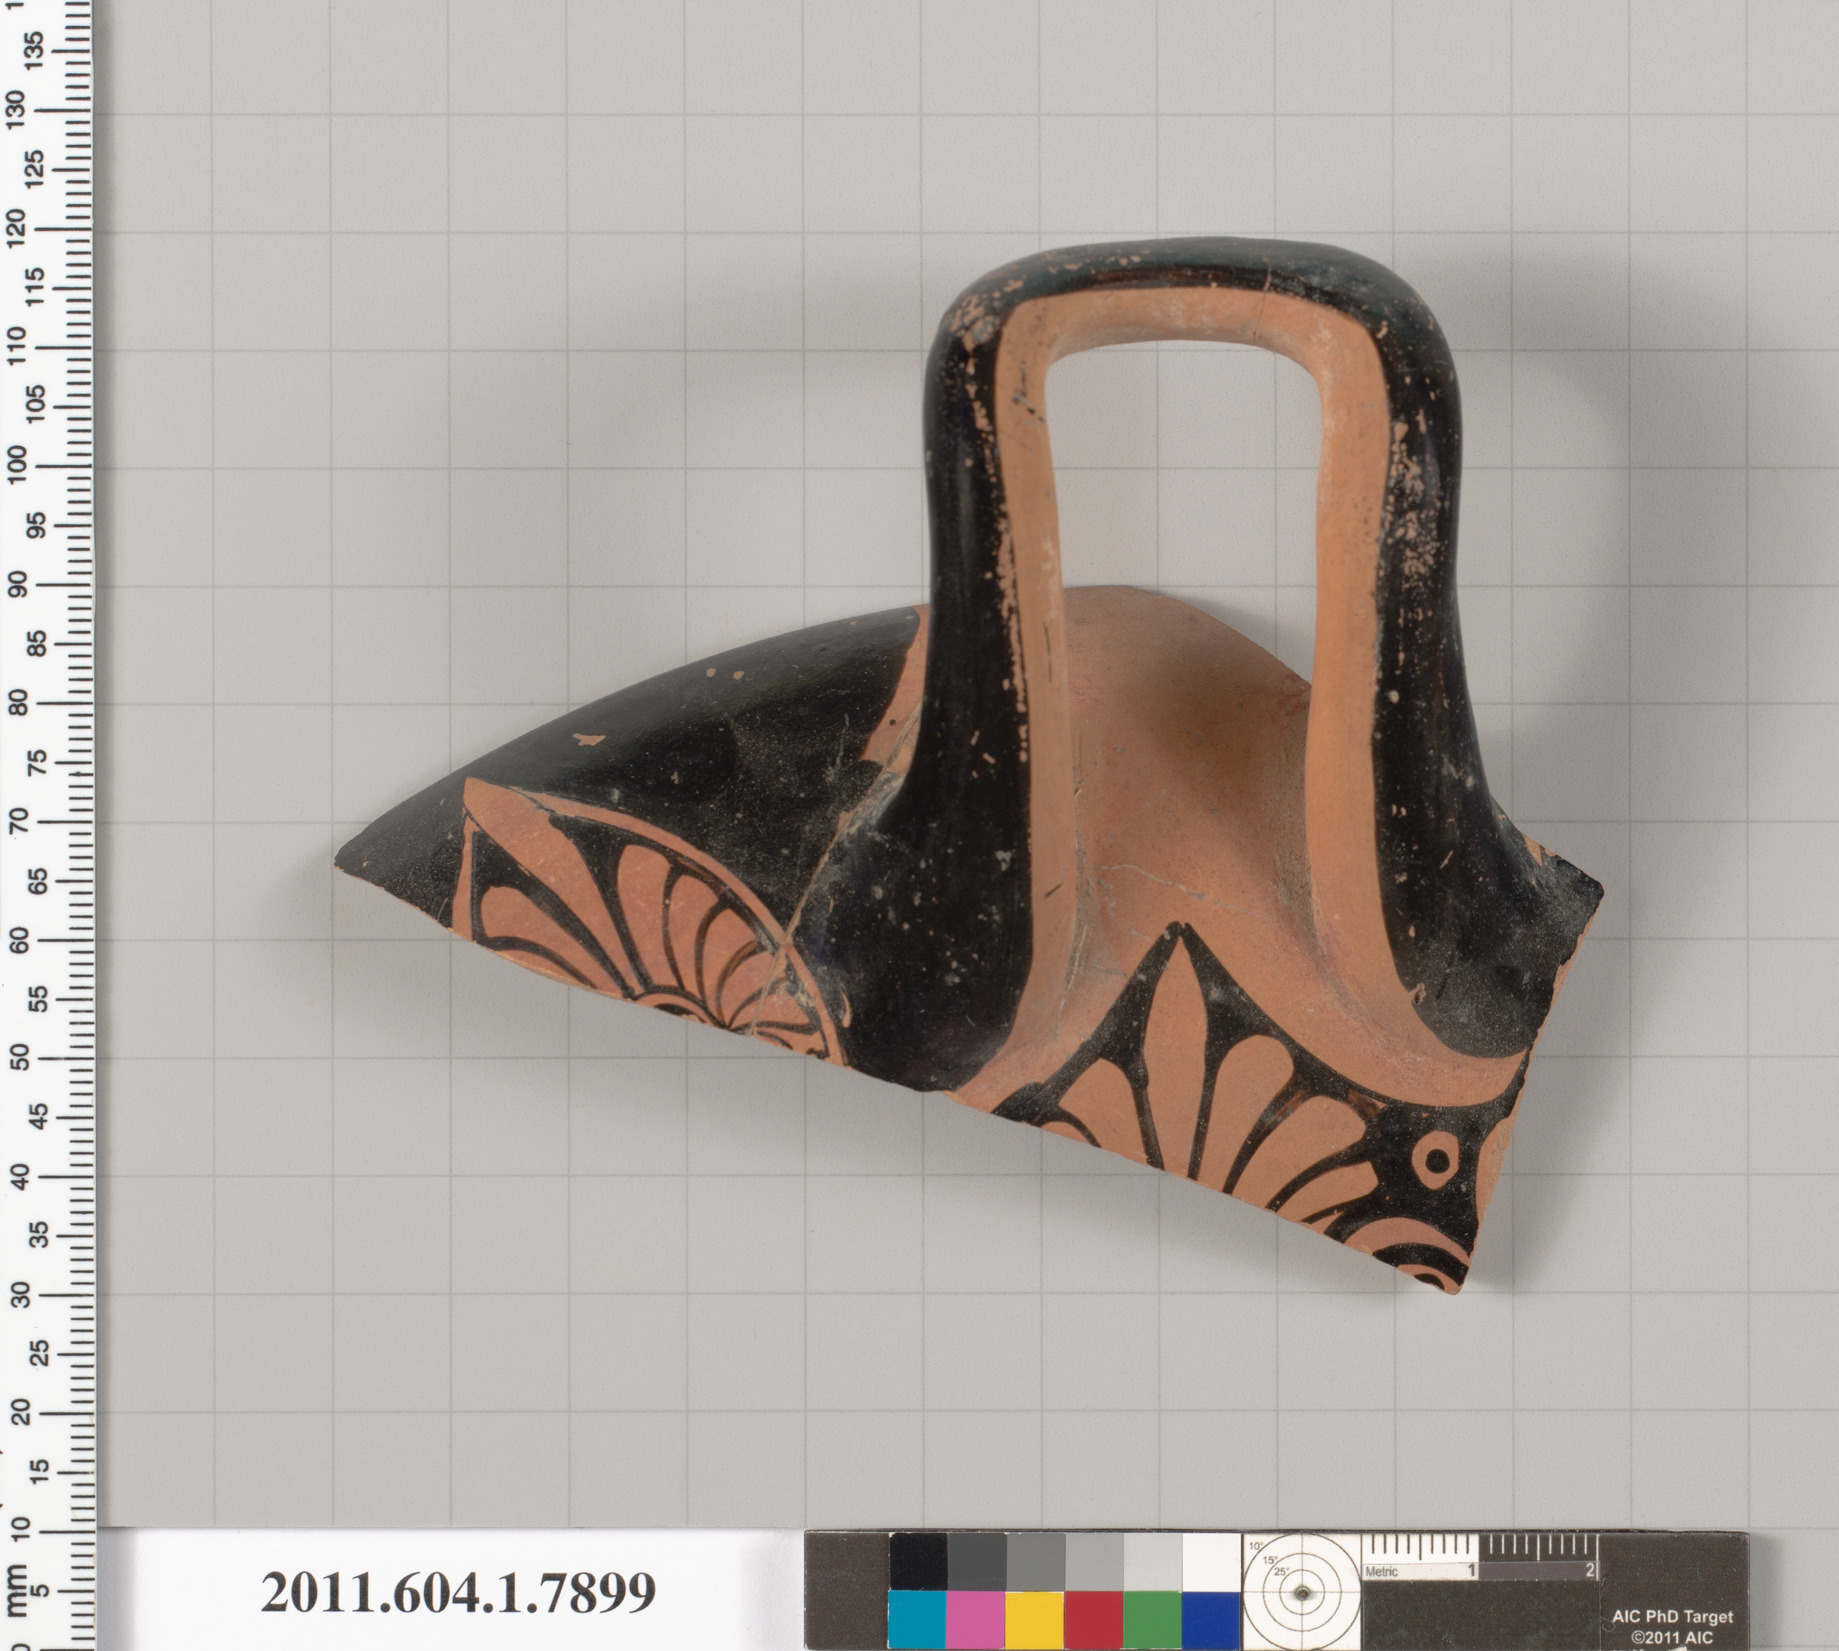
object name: kylix fragment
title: Terracotta rim fragment of a kylix (drinking cup)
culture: greek, attic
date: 450 BCE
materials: terracotta